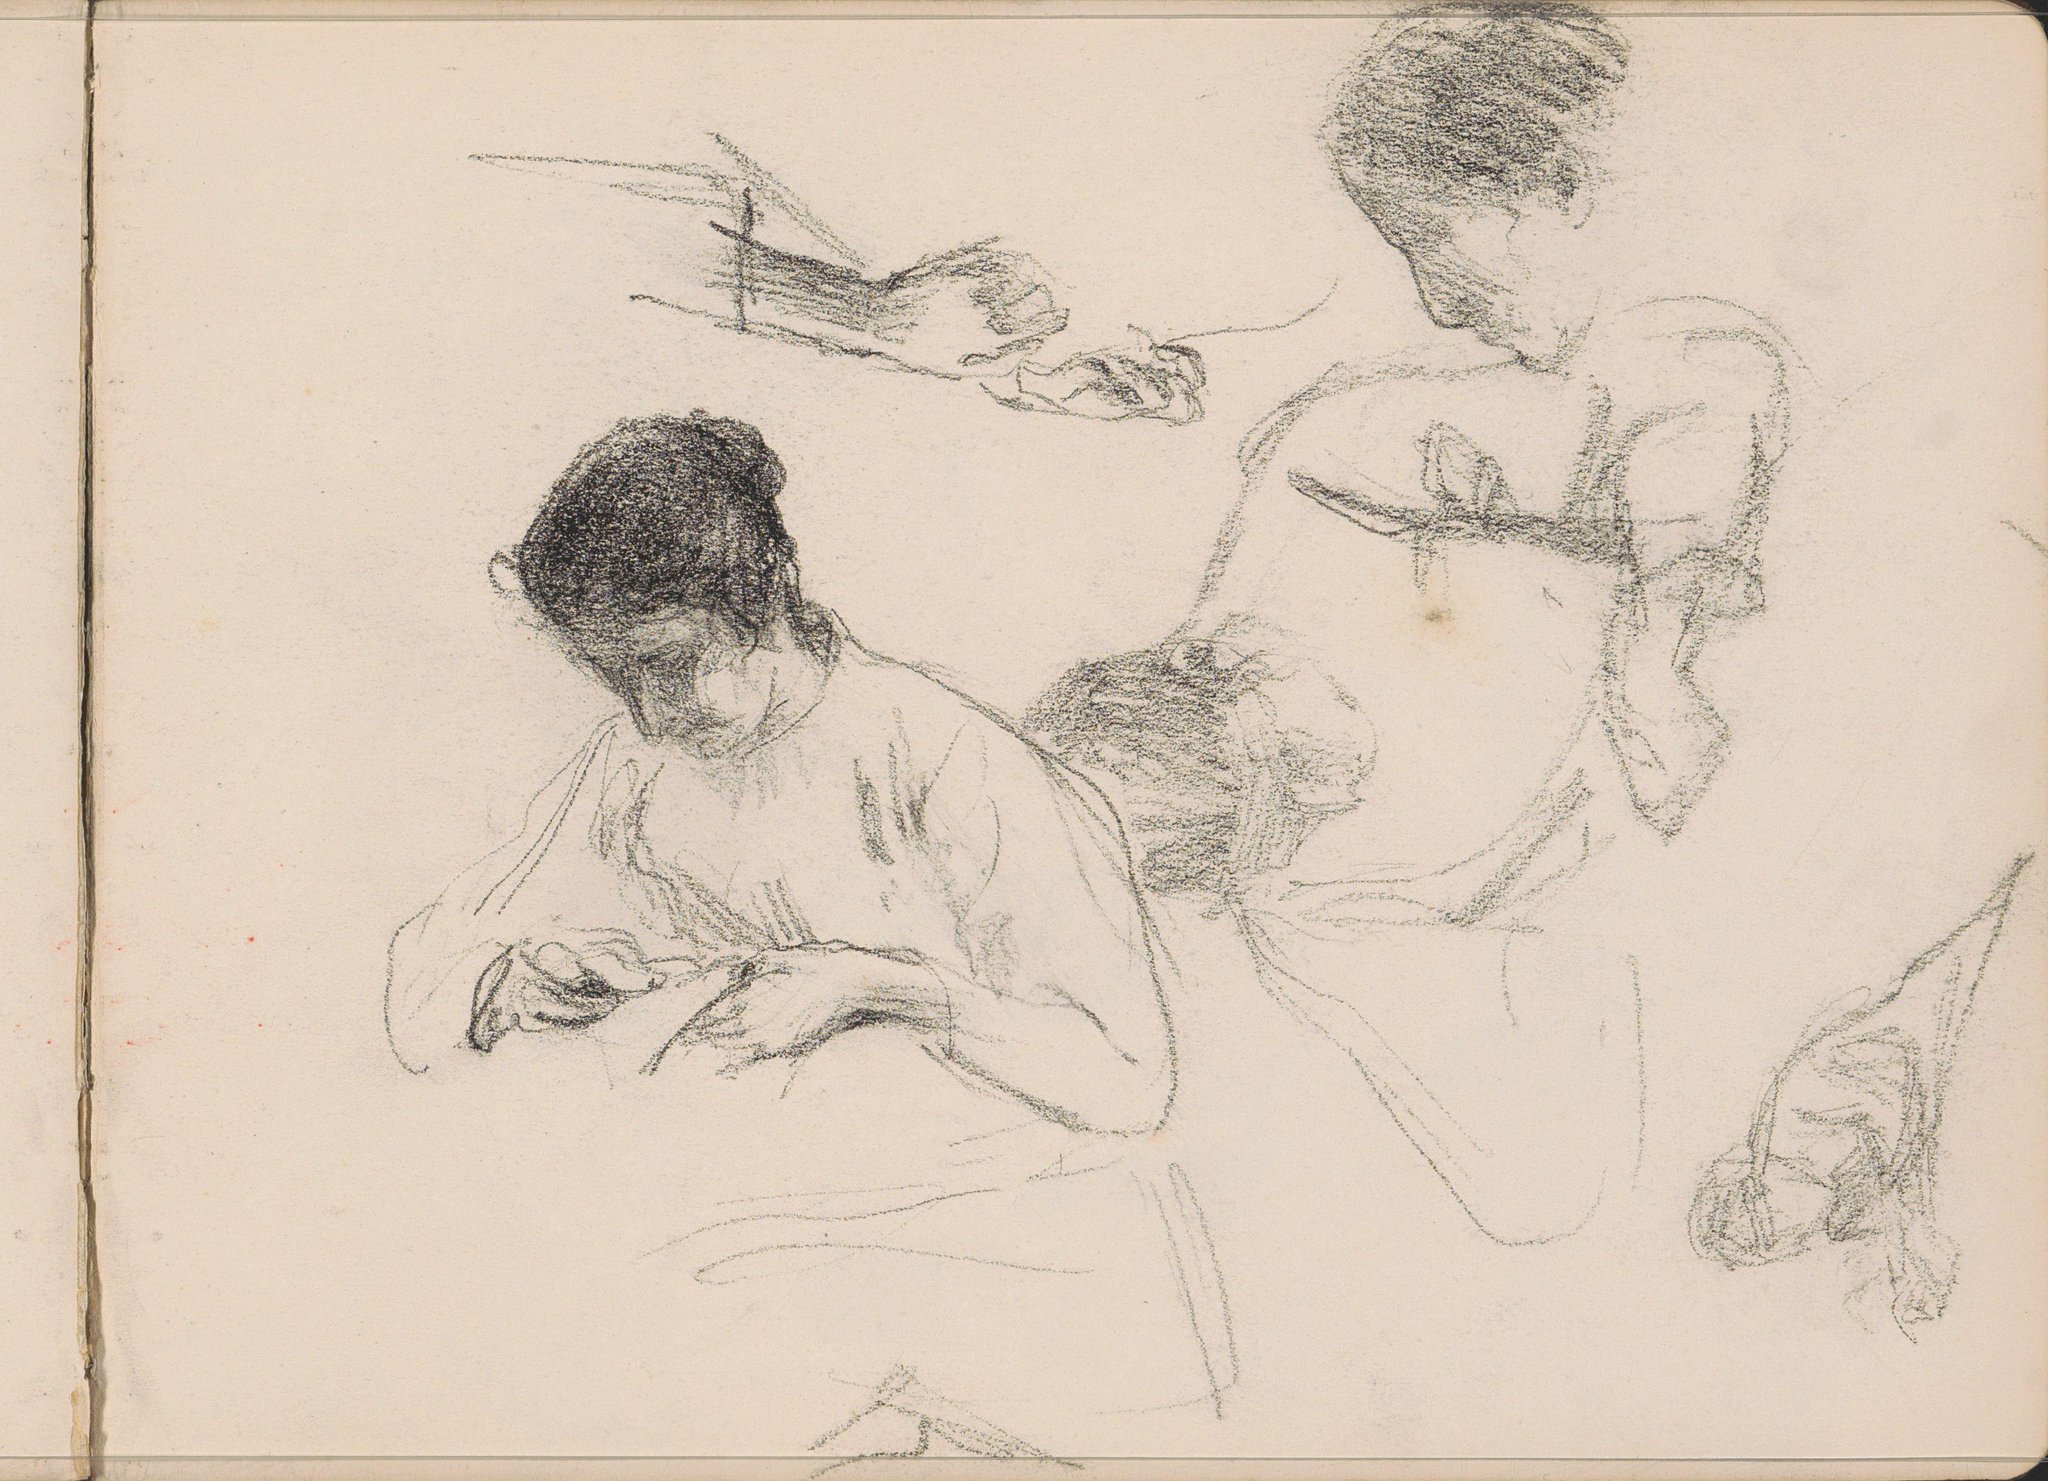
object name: sketchbook leaf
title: Handwerkende vrouw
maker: a.a.l. de grammont-hubrecht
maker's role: draughtsman, painter, print maker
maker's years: 1855-1913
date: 1865-1913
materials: chalk, paper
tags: adult woman, hand, home sewing; repair of clothes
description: Tevens een studie van handen. Blad 31 recto uit een schetsboek met 39 bladen.